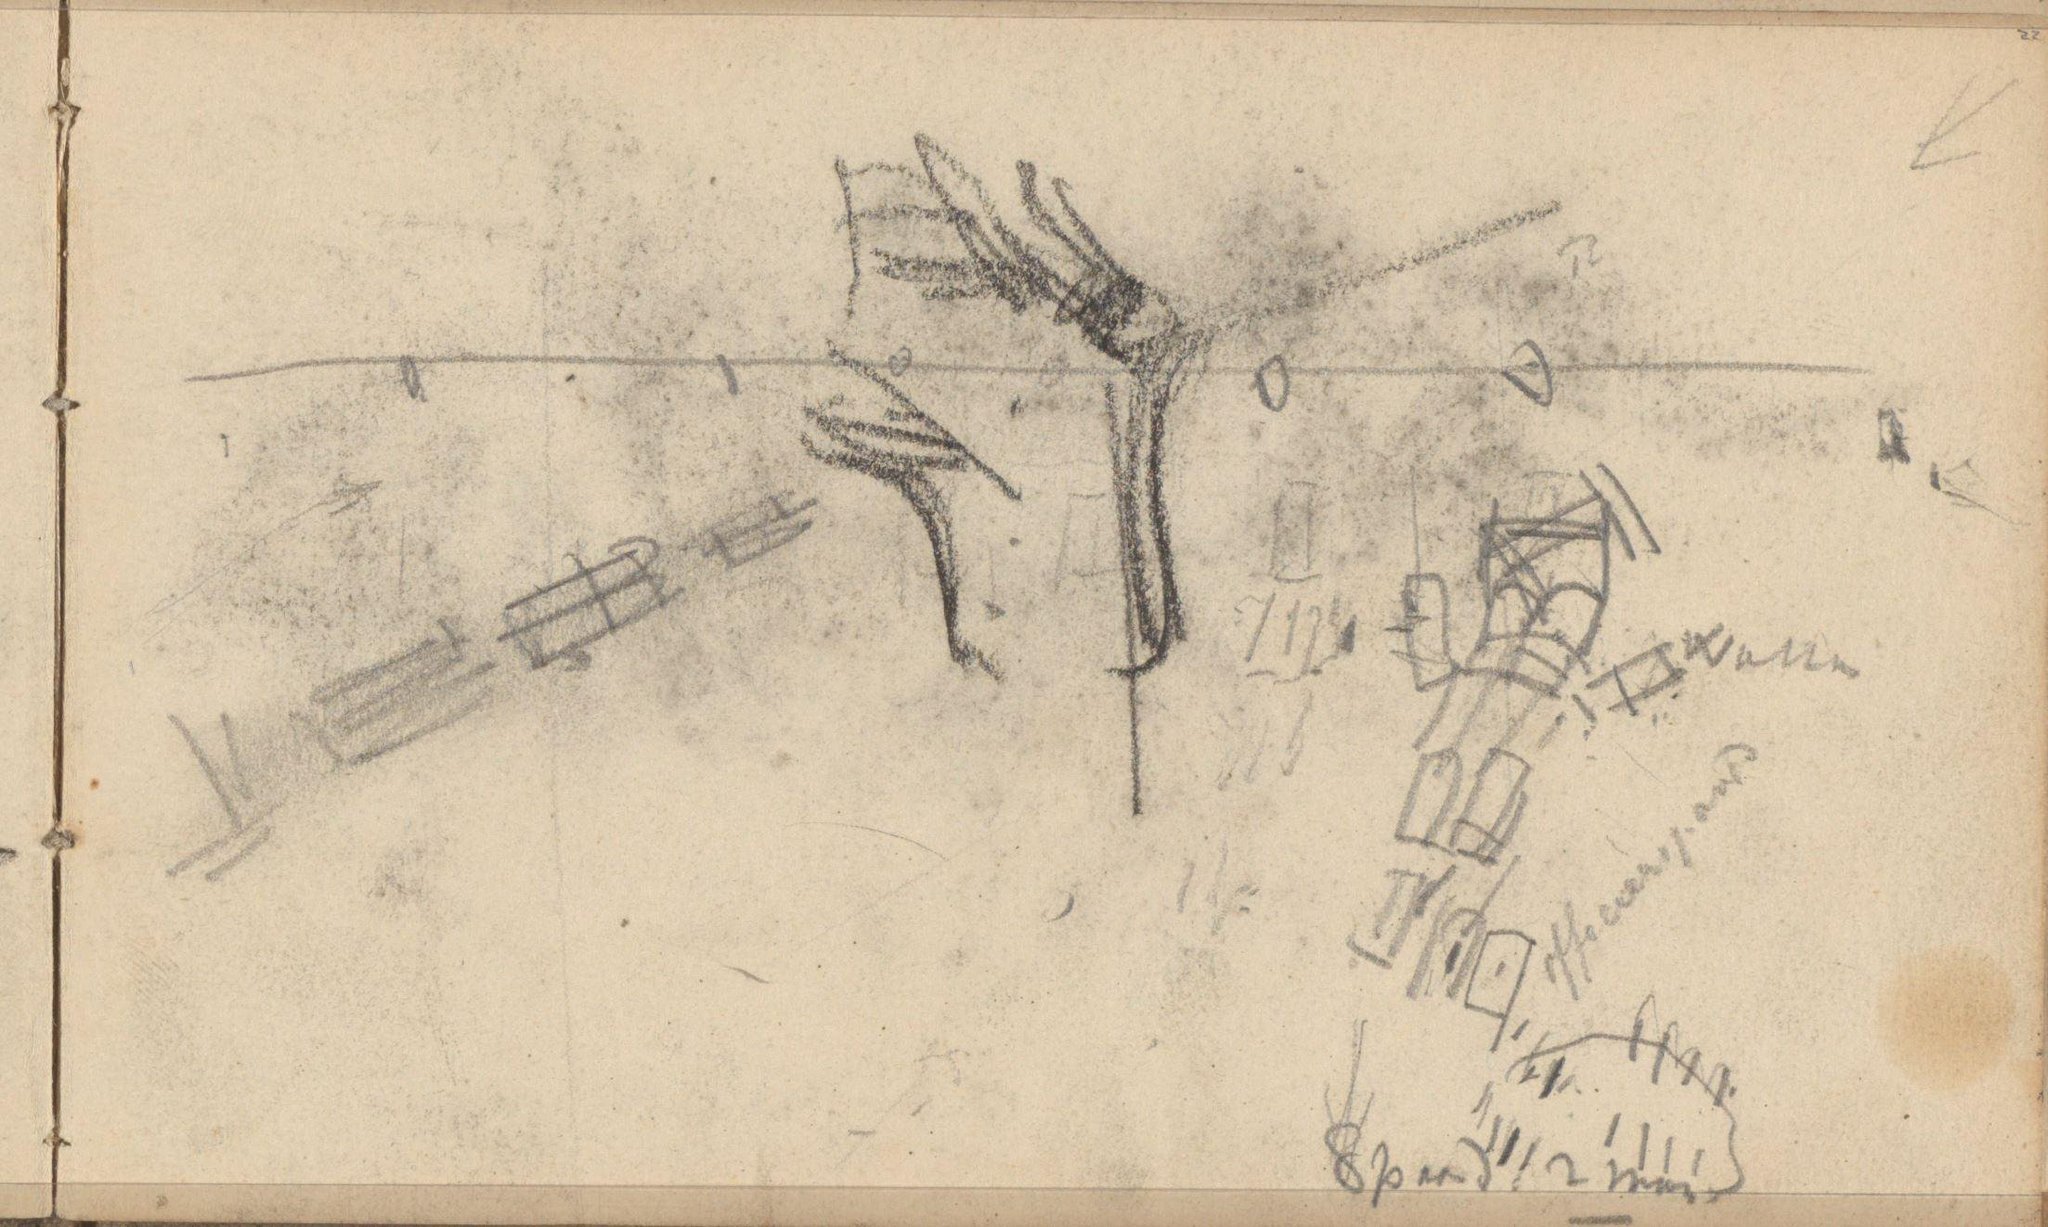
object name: sketchbook leaf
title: Opstelling van de rijdende artillerie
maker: george hendrik breitner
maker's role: draughtsman, painter, print maker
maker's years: 1857-1923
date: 1884-1886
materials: chalk, paper, pencil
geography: the hague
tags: land forces (+ artillery)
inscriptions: annotation: ‘[...]/ officierspaard/ 8 paard 2 man’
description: Eenheid van acht paarden met een officierspaard en twee artilleristen. Pagina 22 uit een schetsboek met 35 bladen.